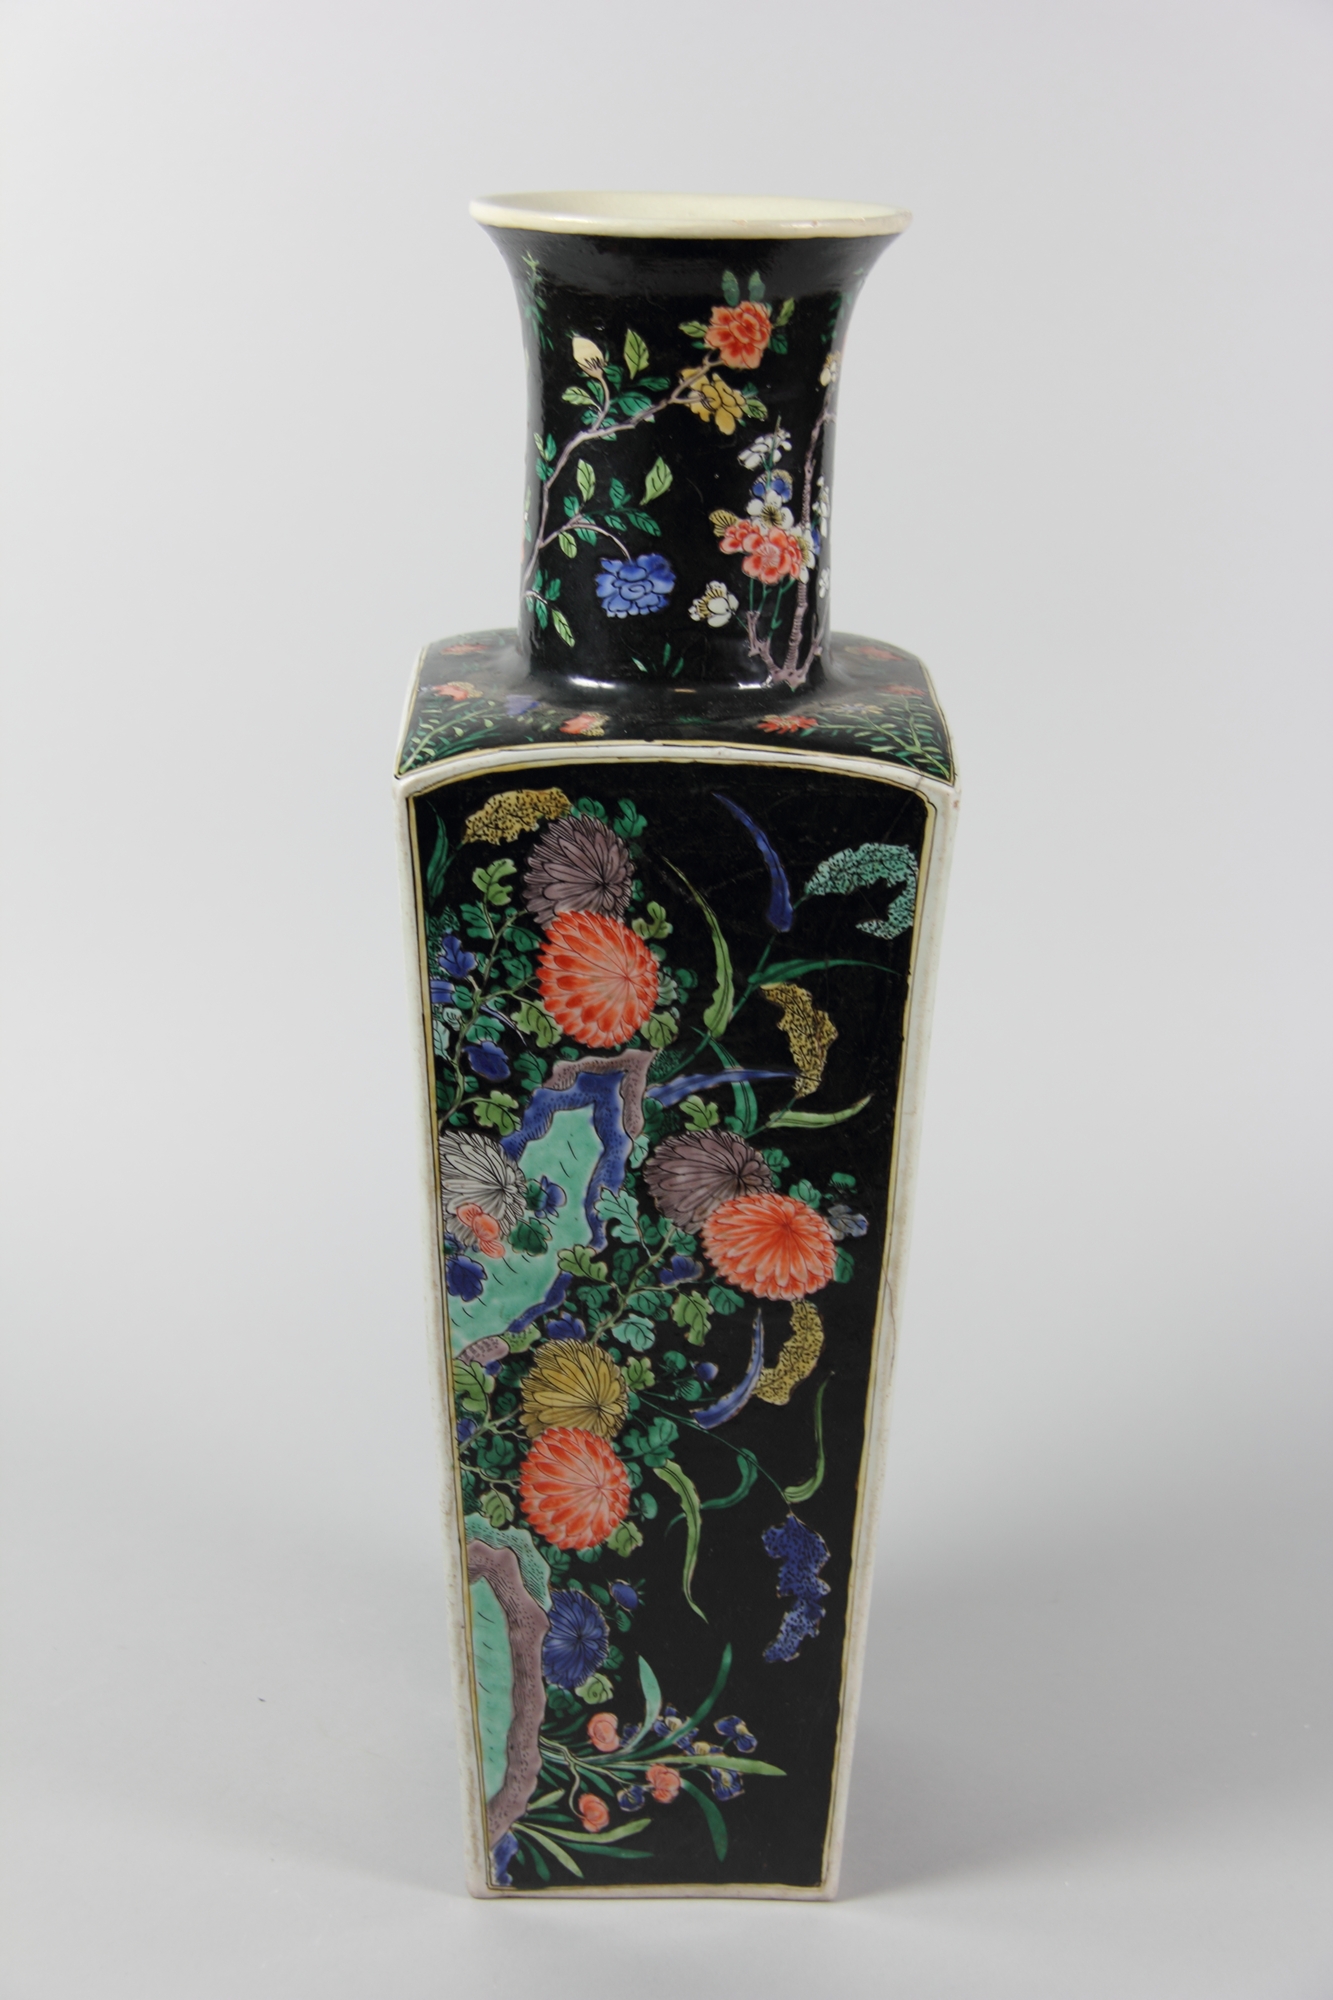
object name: vase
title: Square vase with scenes of four seasons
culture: chinese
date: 1801-1900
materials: enamel, porcelain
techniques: painting, polychrome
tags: flowers